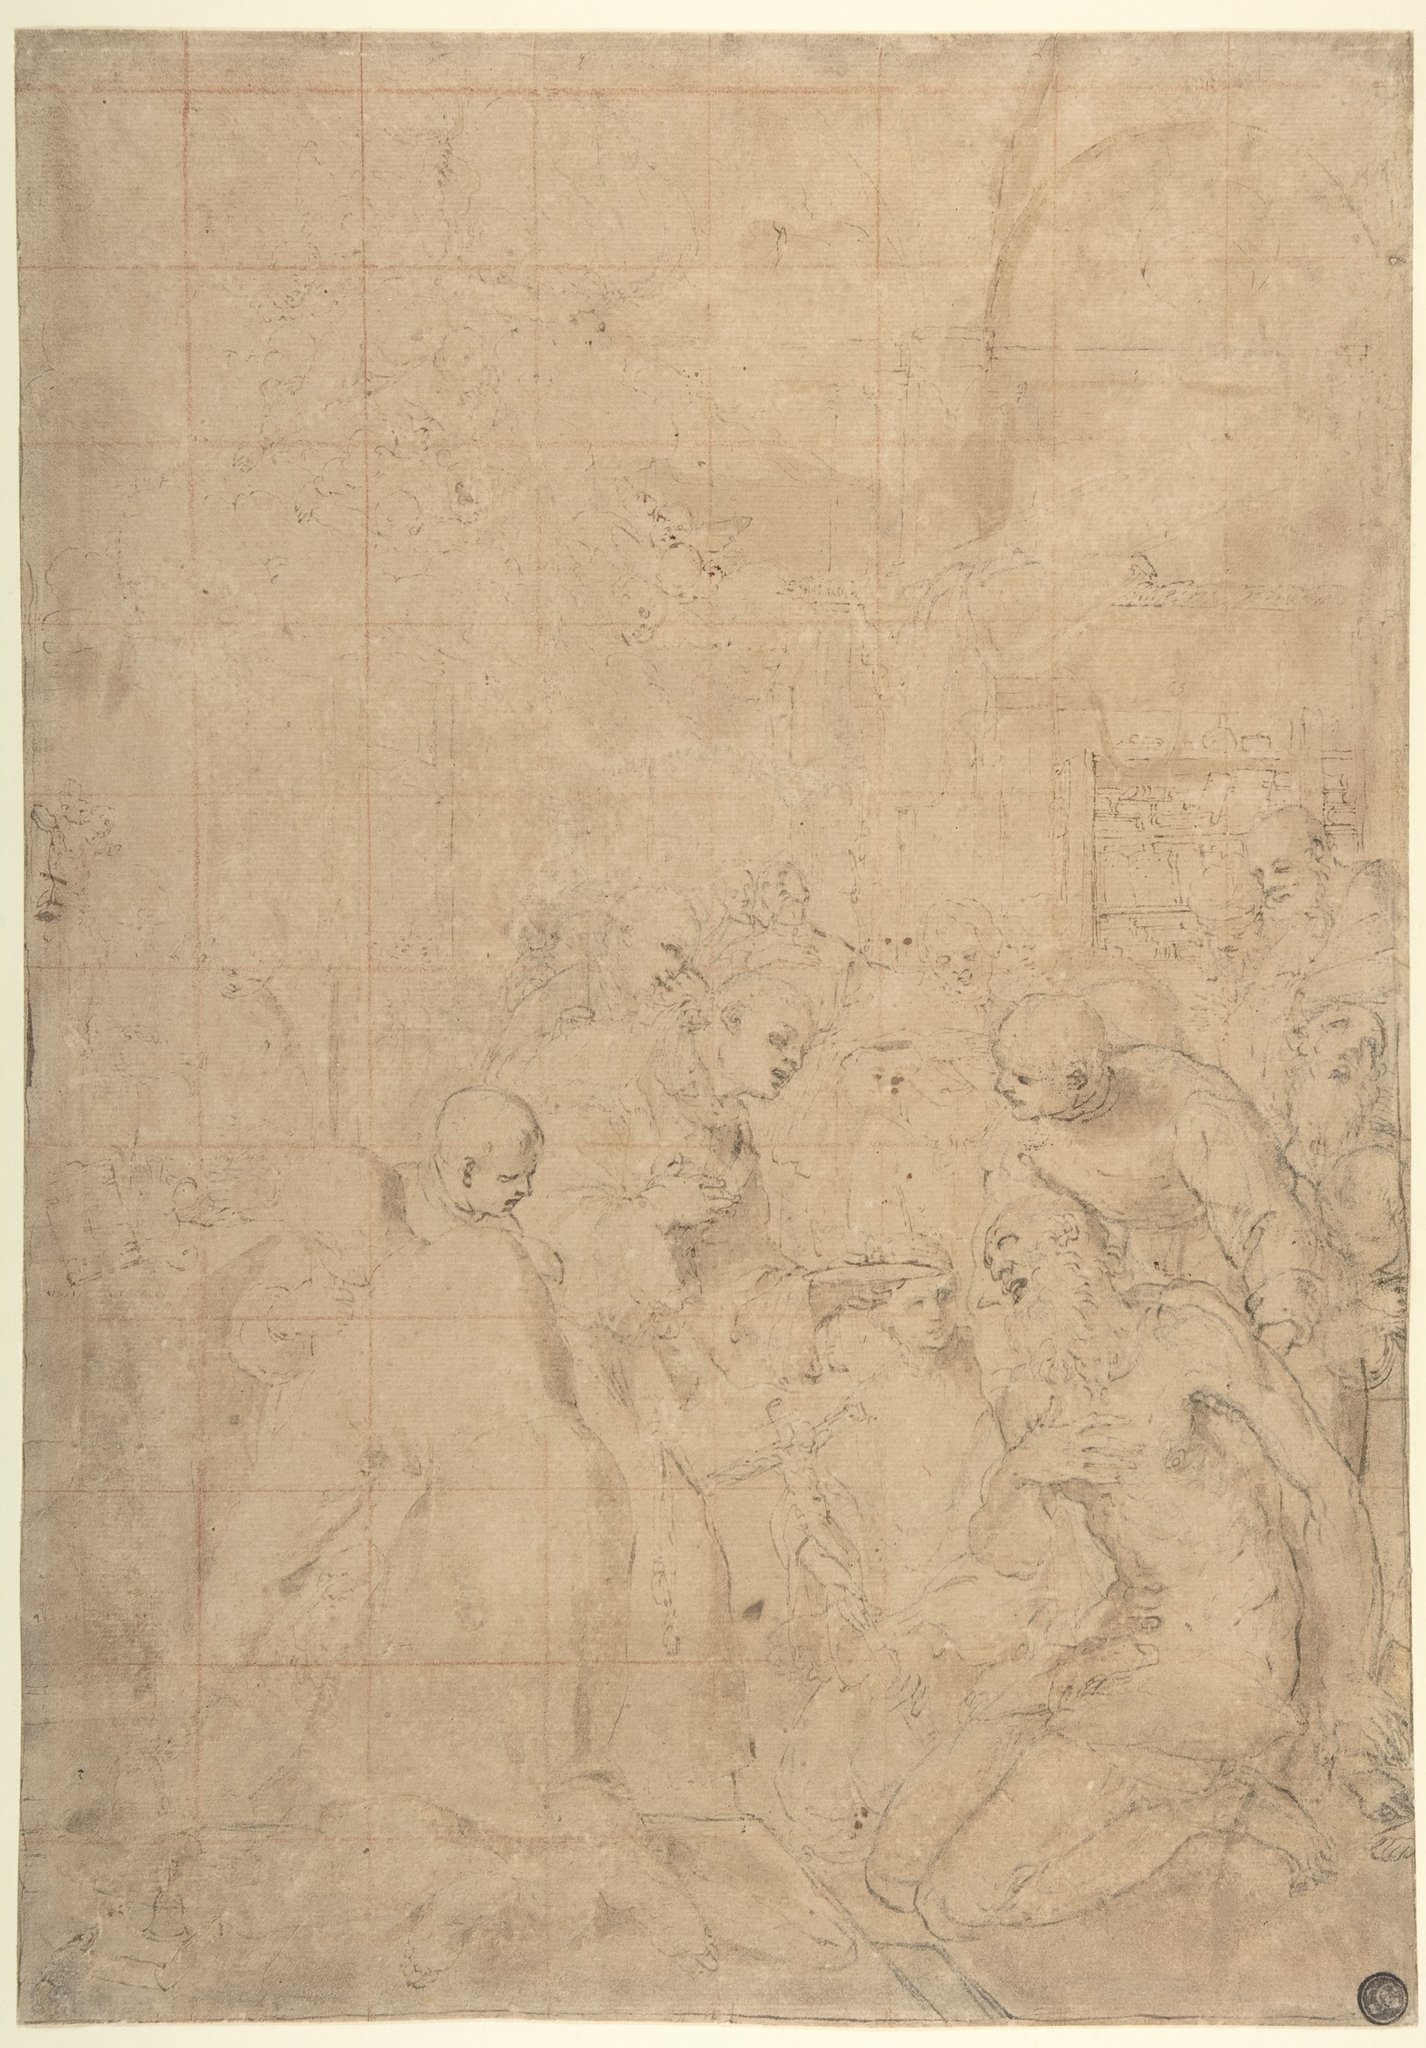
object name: drawing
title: The Last Communion of Saint Jerome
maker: ludovico carracci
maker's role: artist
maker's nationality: italian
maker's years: 1555-1619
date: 1555-1619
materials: chalk, ink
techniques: brush, pen, drawing, wash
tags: human figures,saint jerome